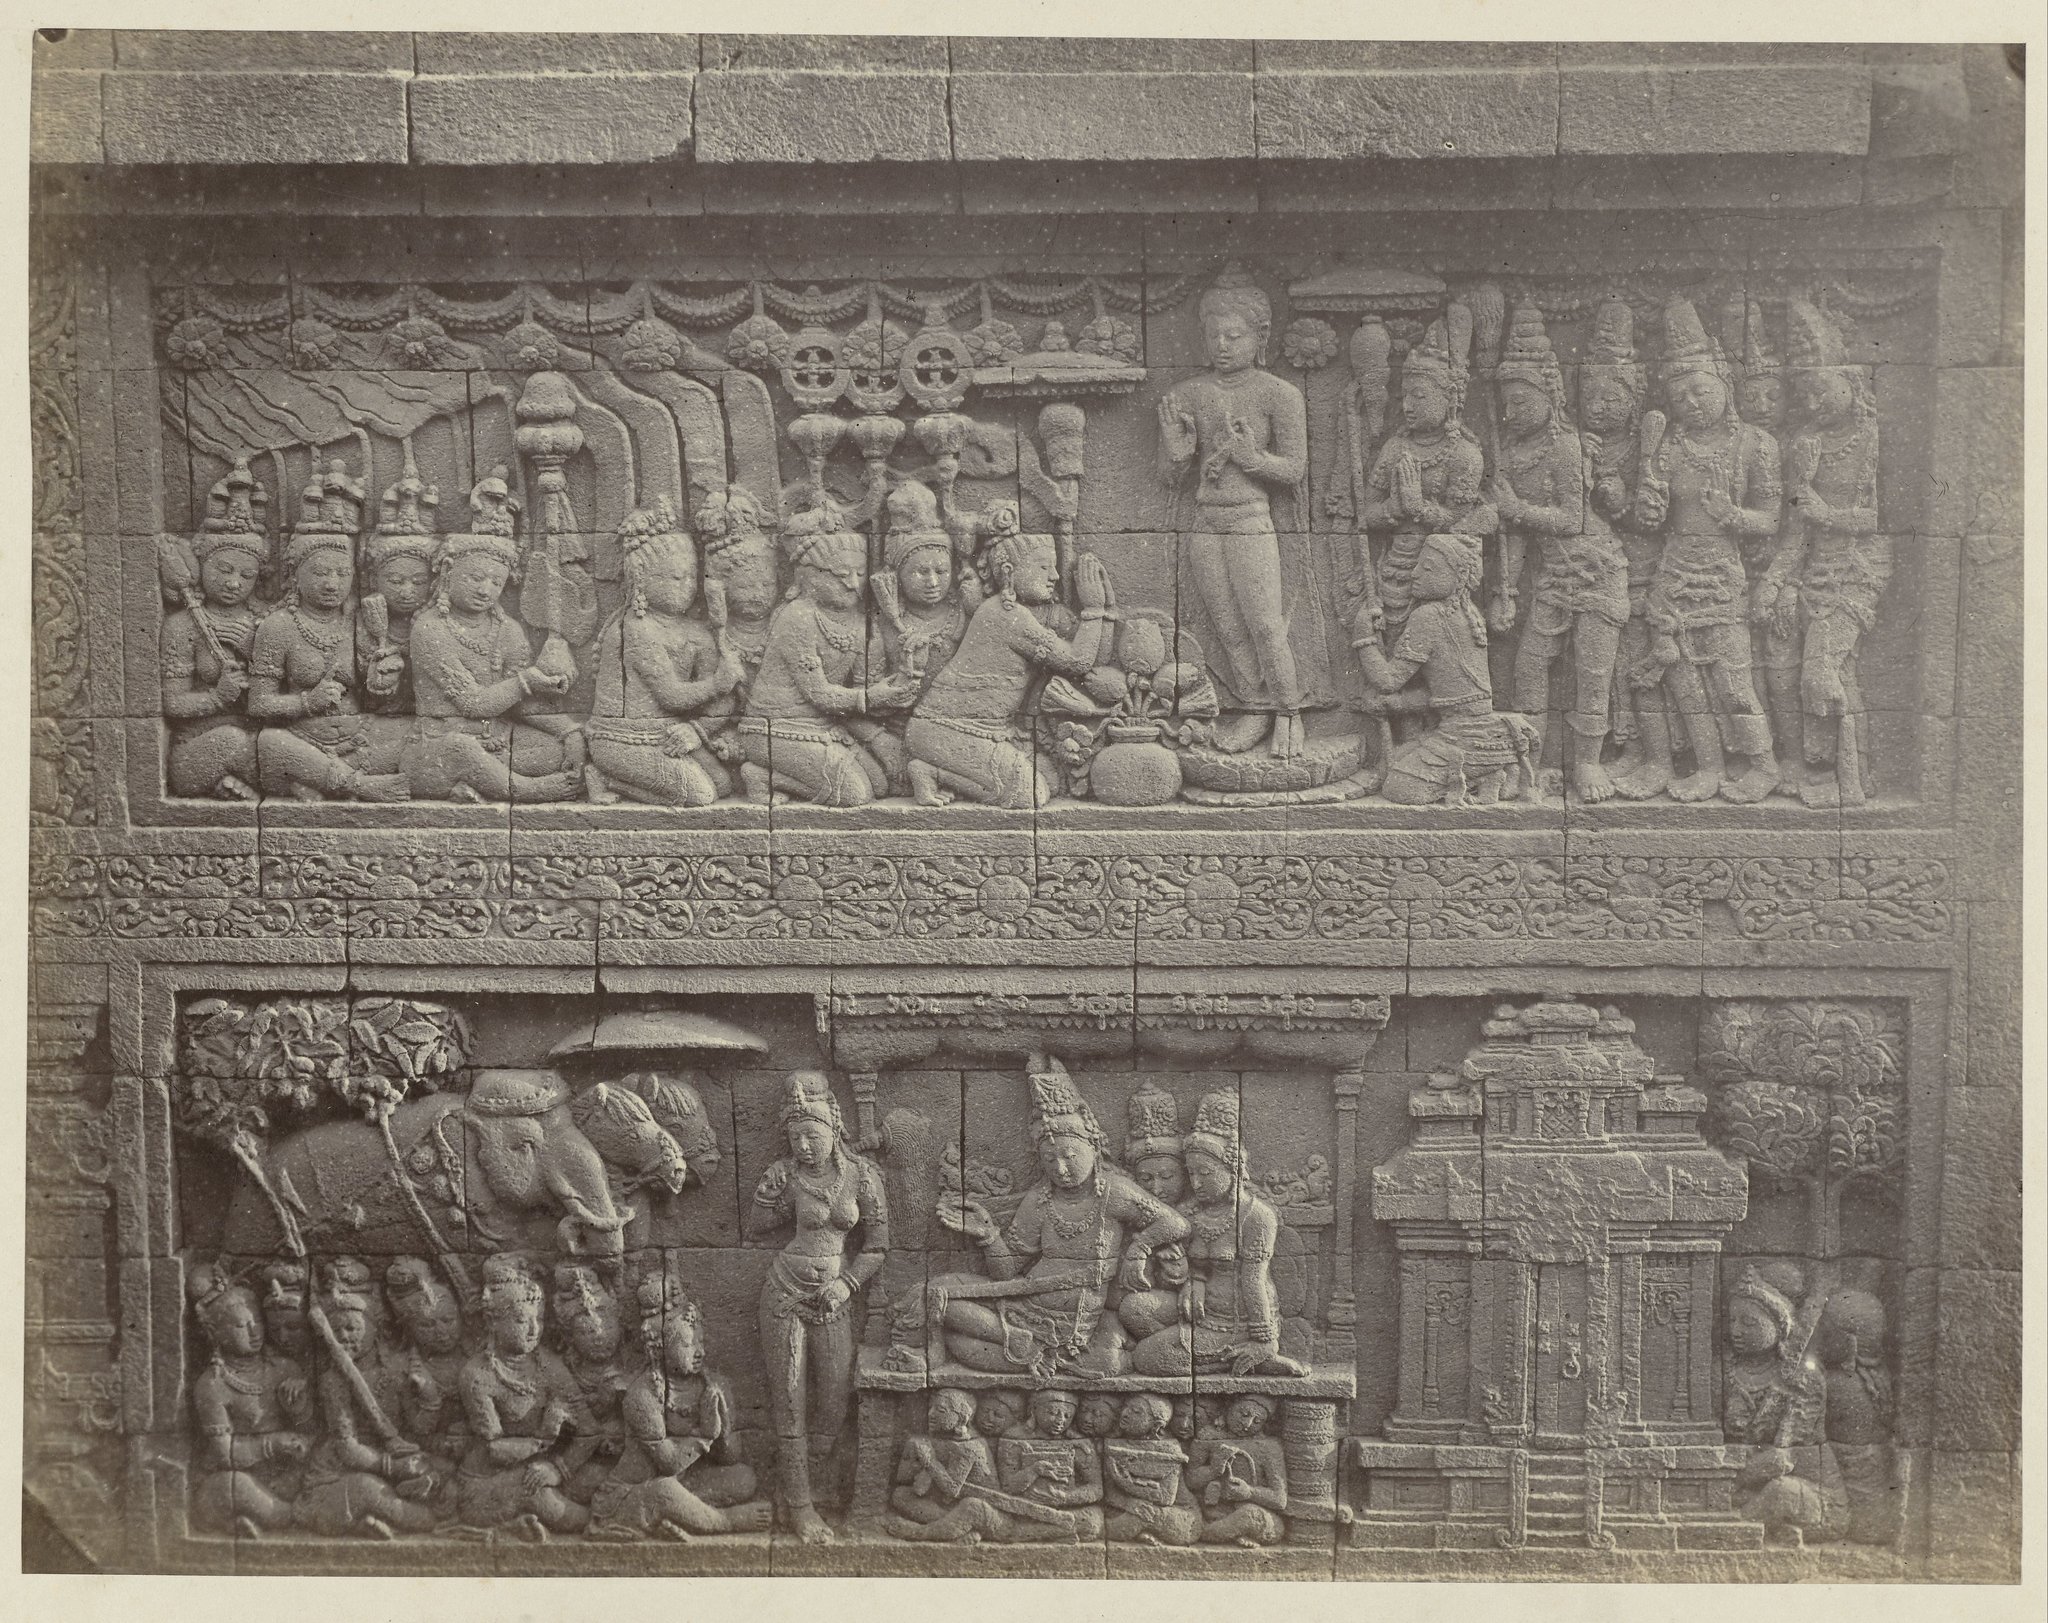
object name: photograph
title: Idem 2e gaanderij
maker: isidore kinsbergen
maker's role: fotograaf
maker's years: 1821-1905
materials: cardboard, paper, photographic support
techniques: albumen print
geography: java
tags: borobudur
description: Gallery I, main wall, north side 49 (top): Relief 1a-91, Lalitavistara relief, Siddhartha honoured by god Brahma and the naga king Kalika. 49 (bottom): relief 1b-91, Unidentified scene. Borobudur village, Magelang district, Central Java province, 778-824 AD.